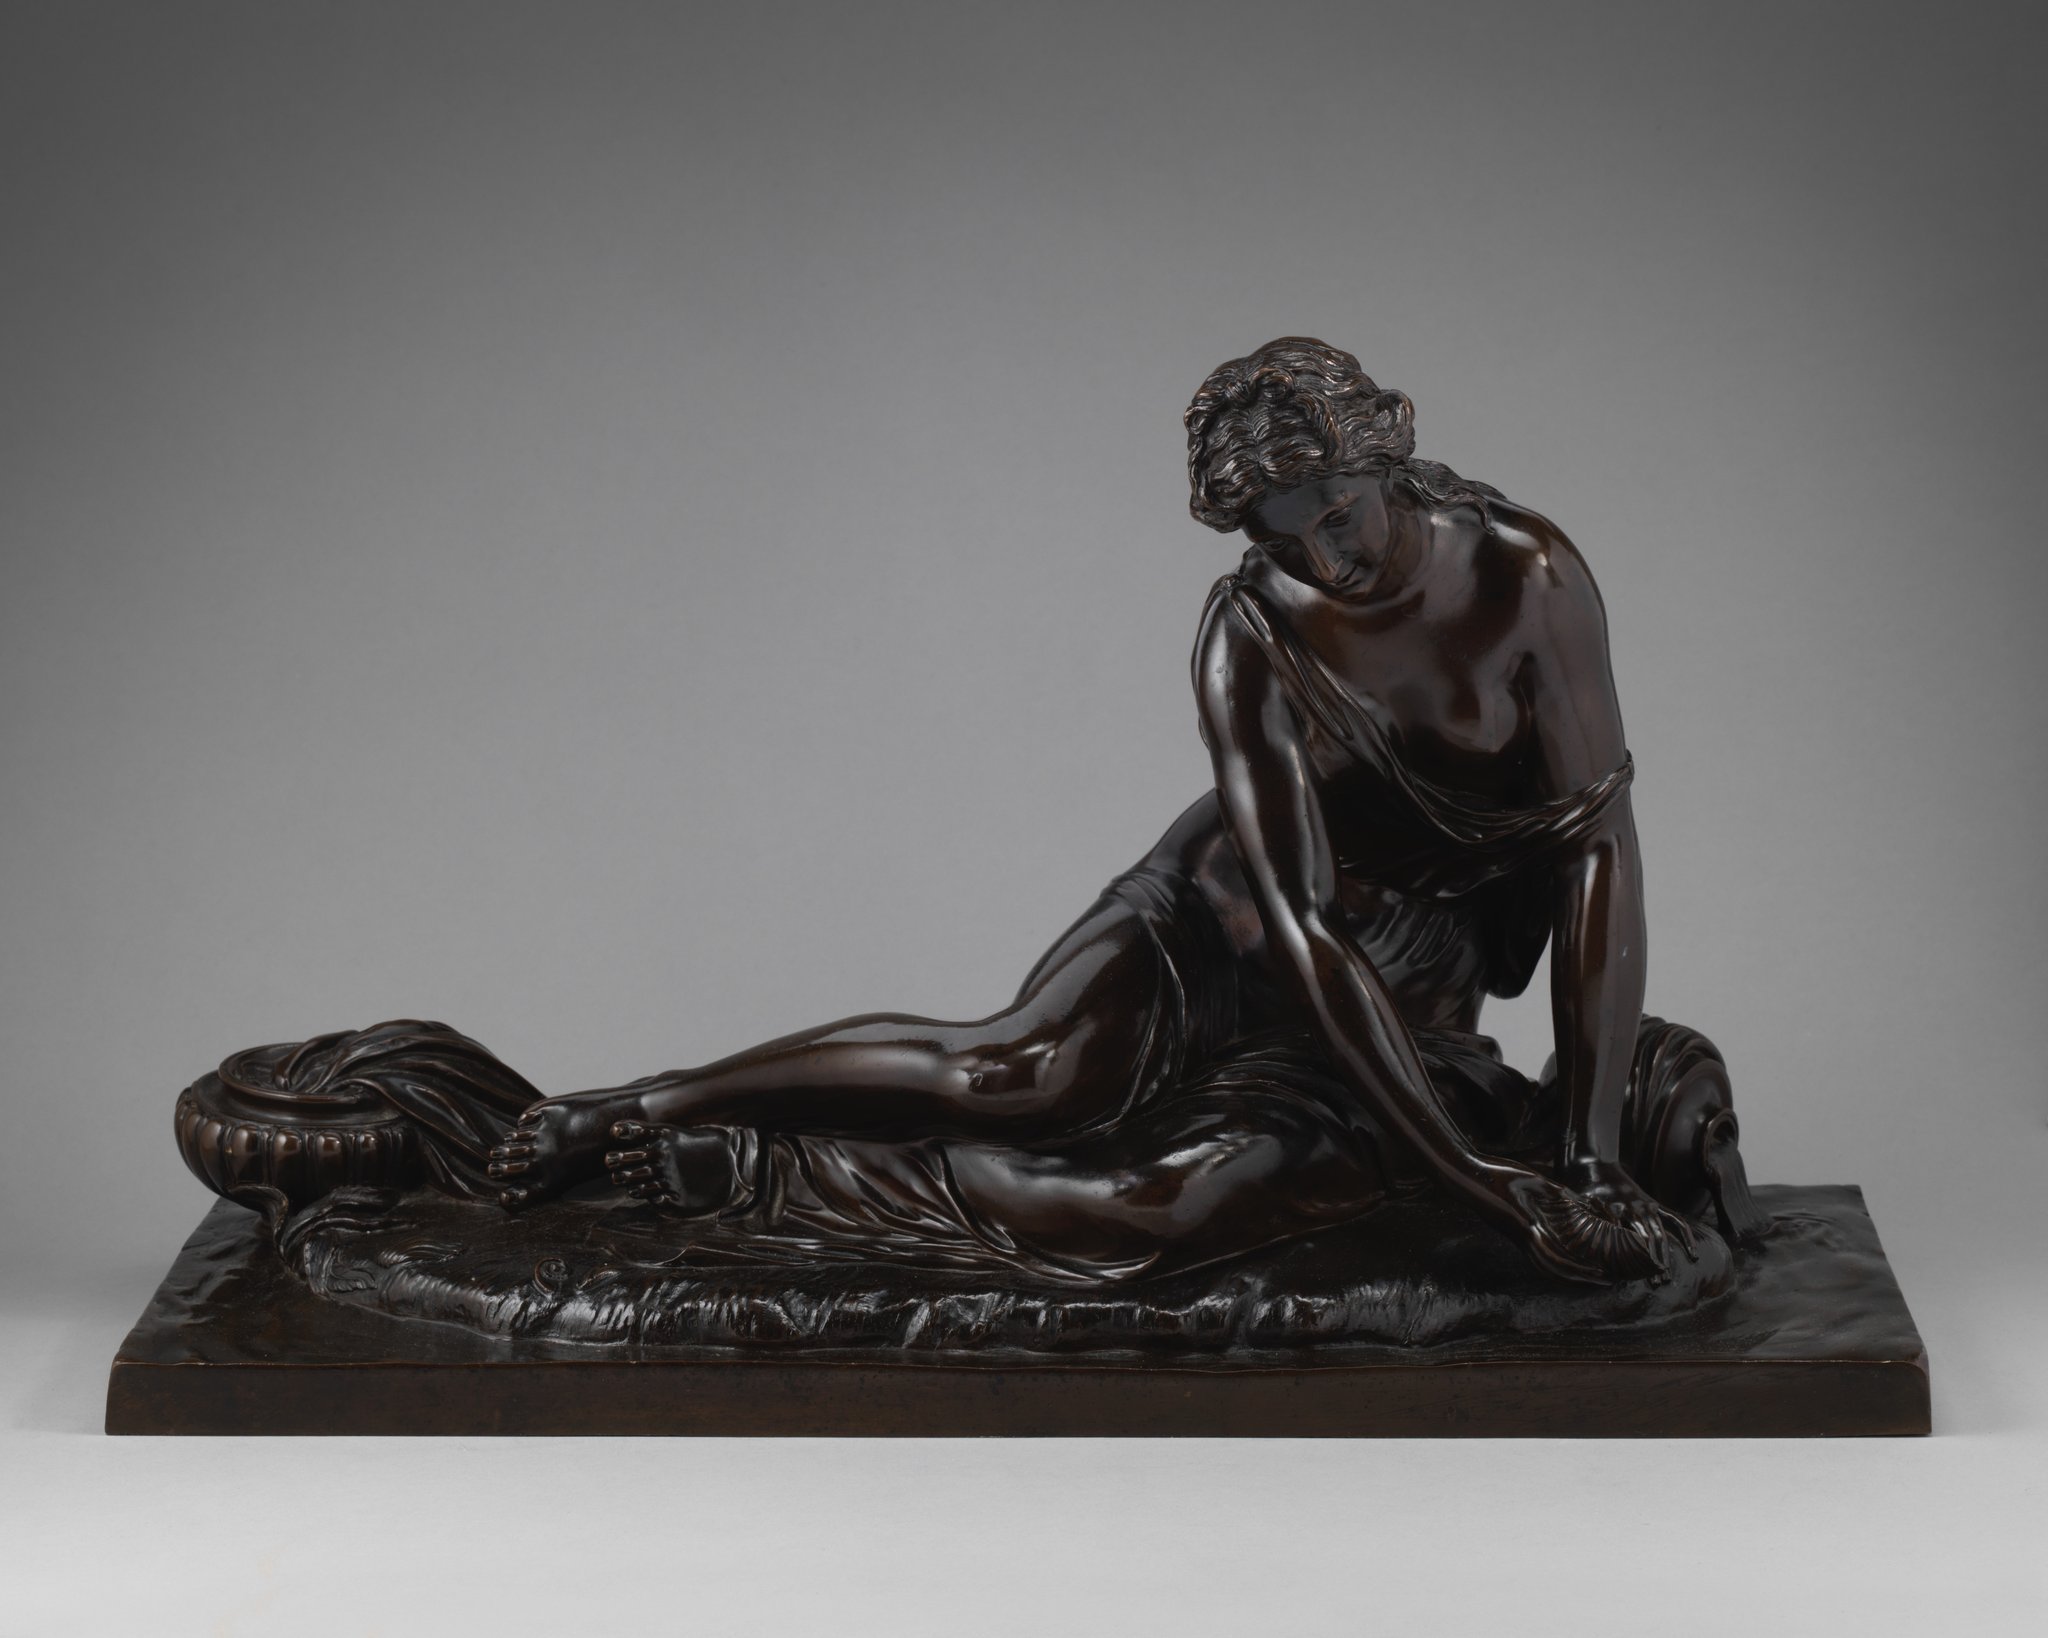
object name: statuette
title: Nymph with a Shell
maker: antoine coysevox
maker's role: modeler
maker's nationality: french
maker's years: 1640-1724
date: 1667-1700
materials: bronze